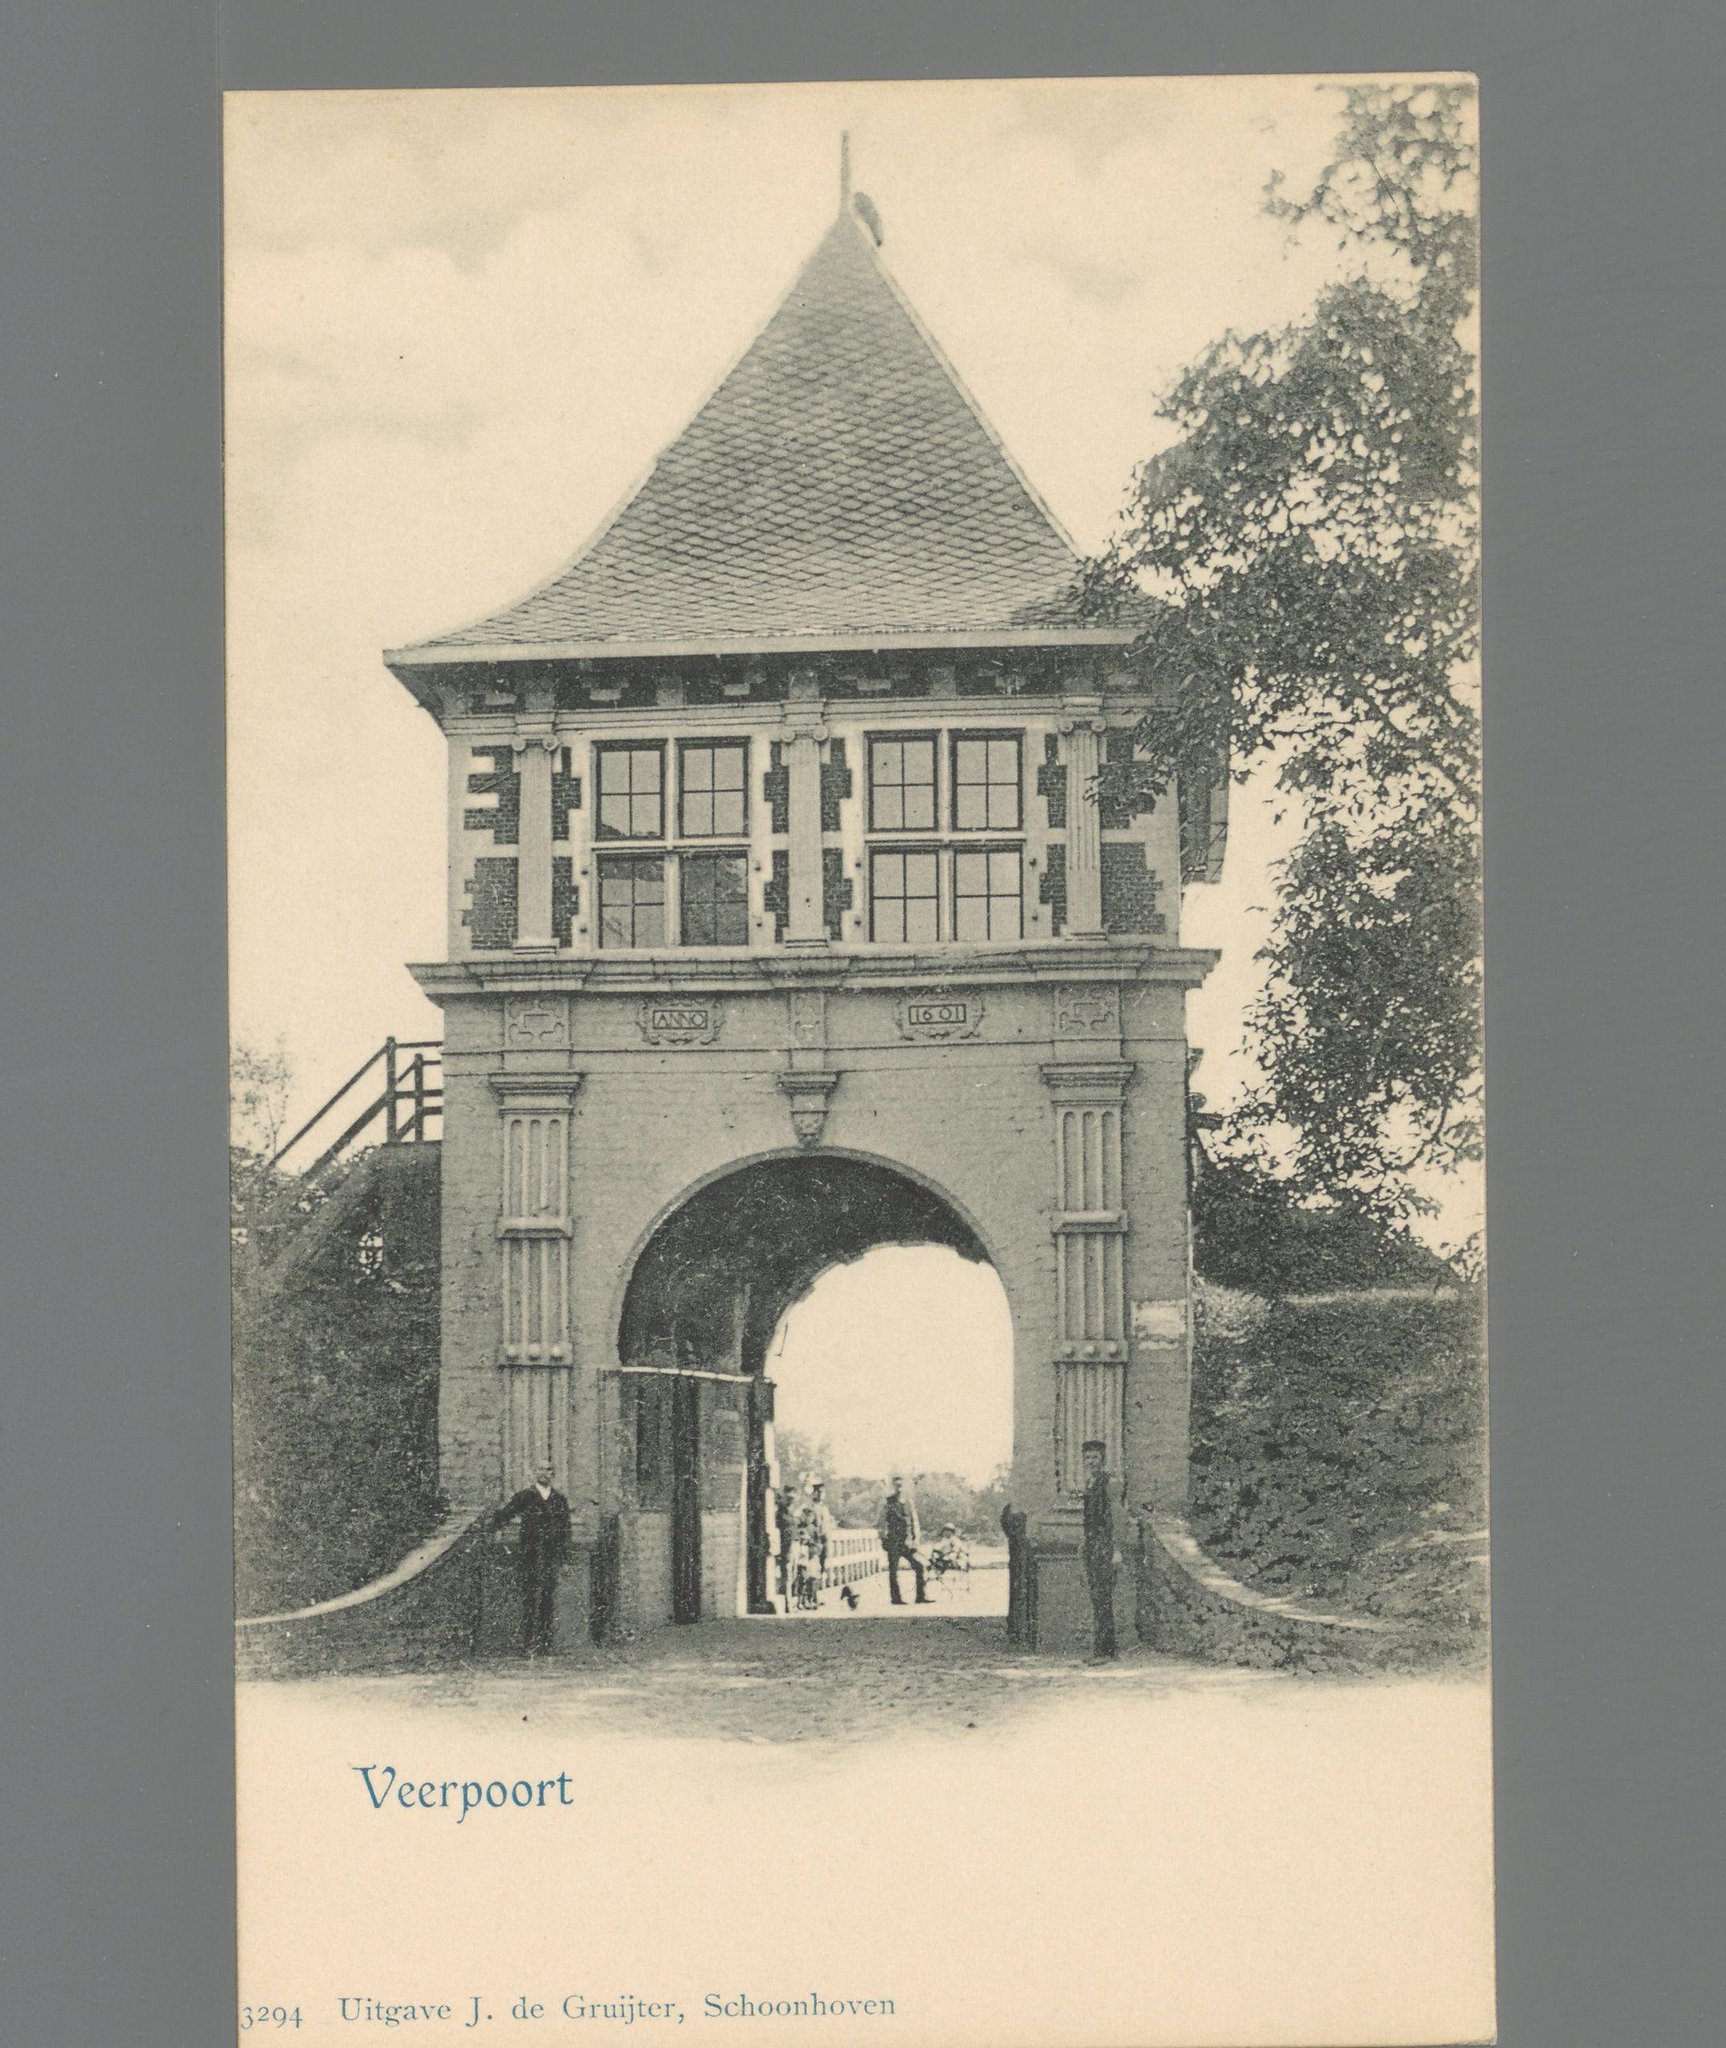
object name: ansichtkaart, prentbriefkaart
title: Veerpoort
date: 1897-1905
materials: cardboard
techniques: photograph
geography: schoonhoven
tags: bridge, city-gate